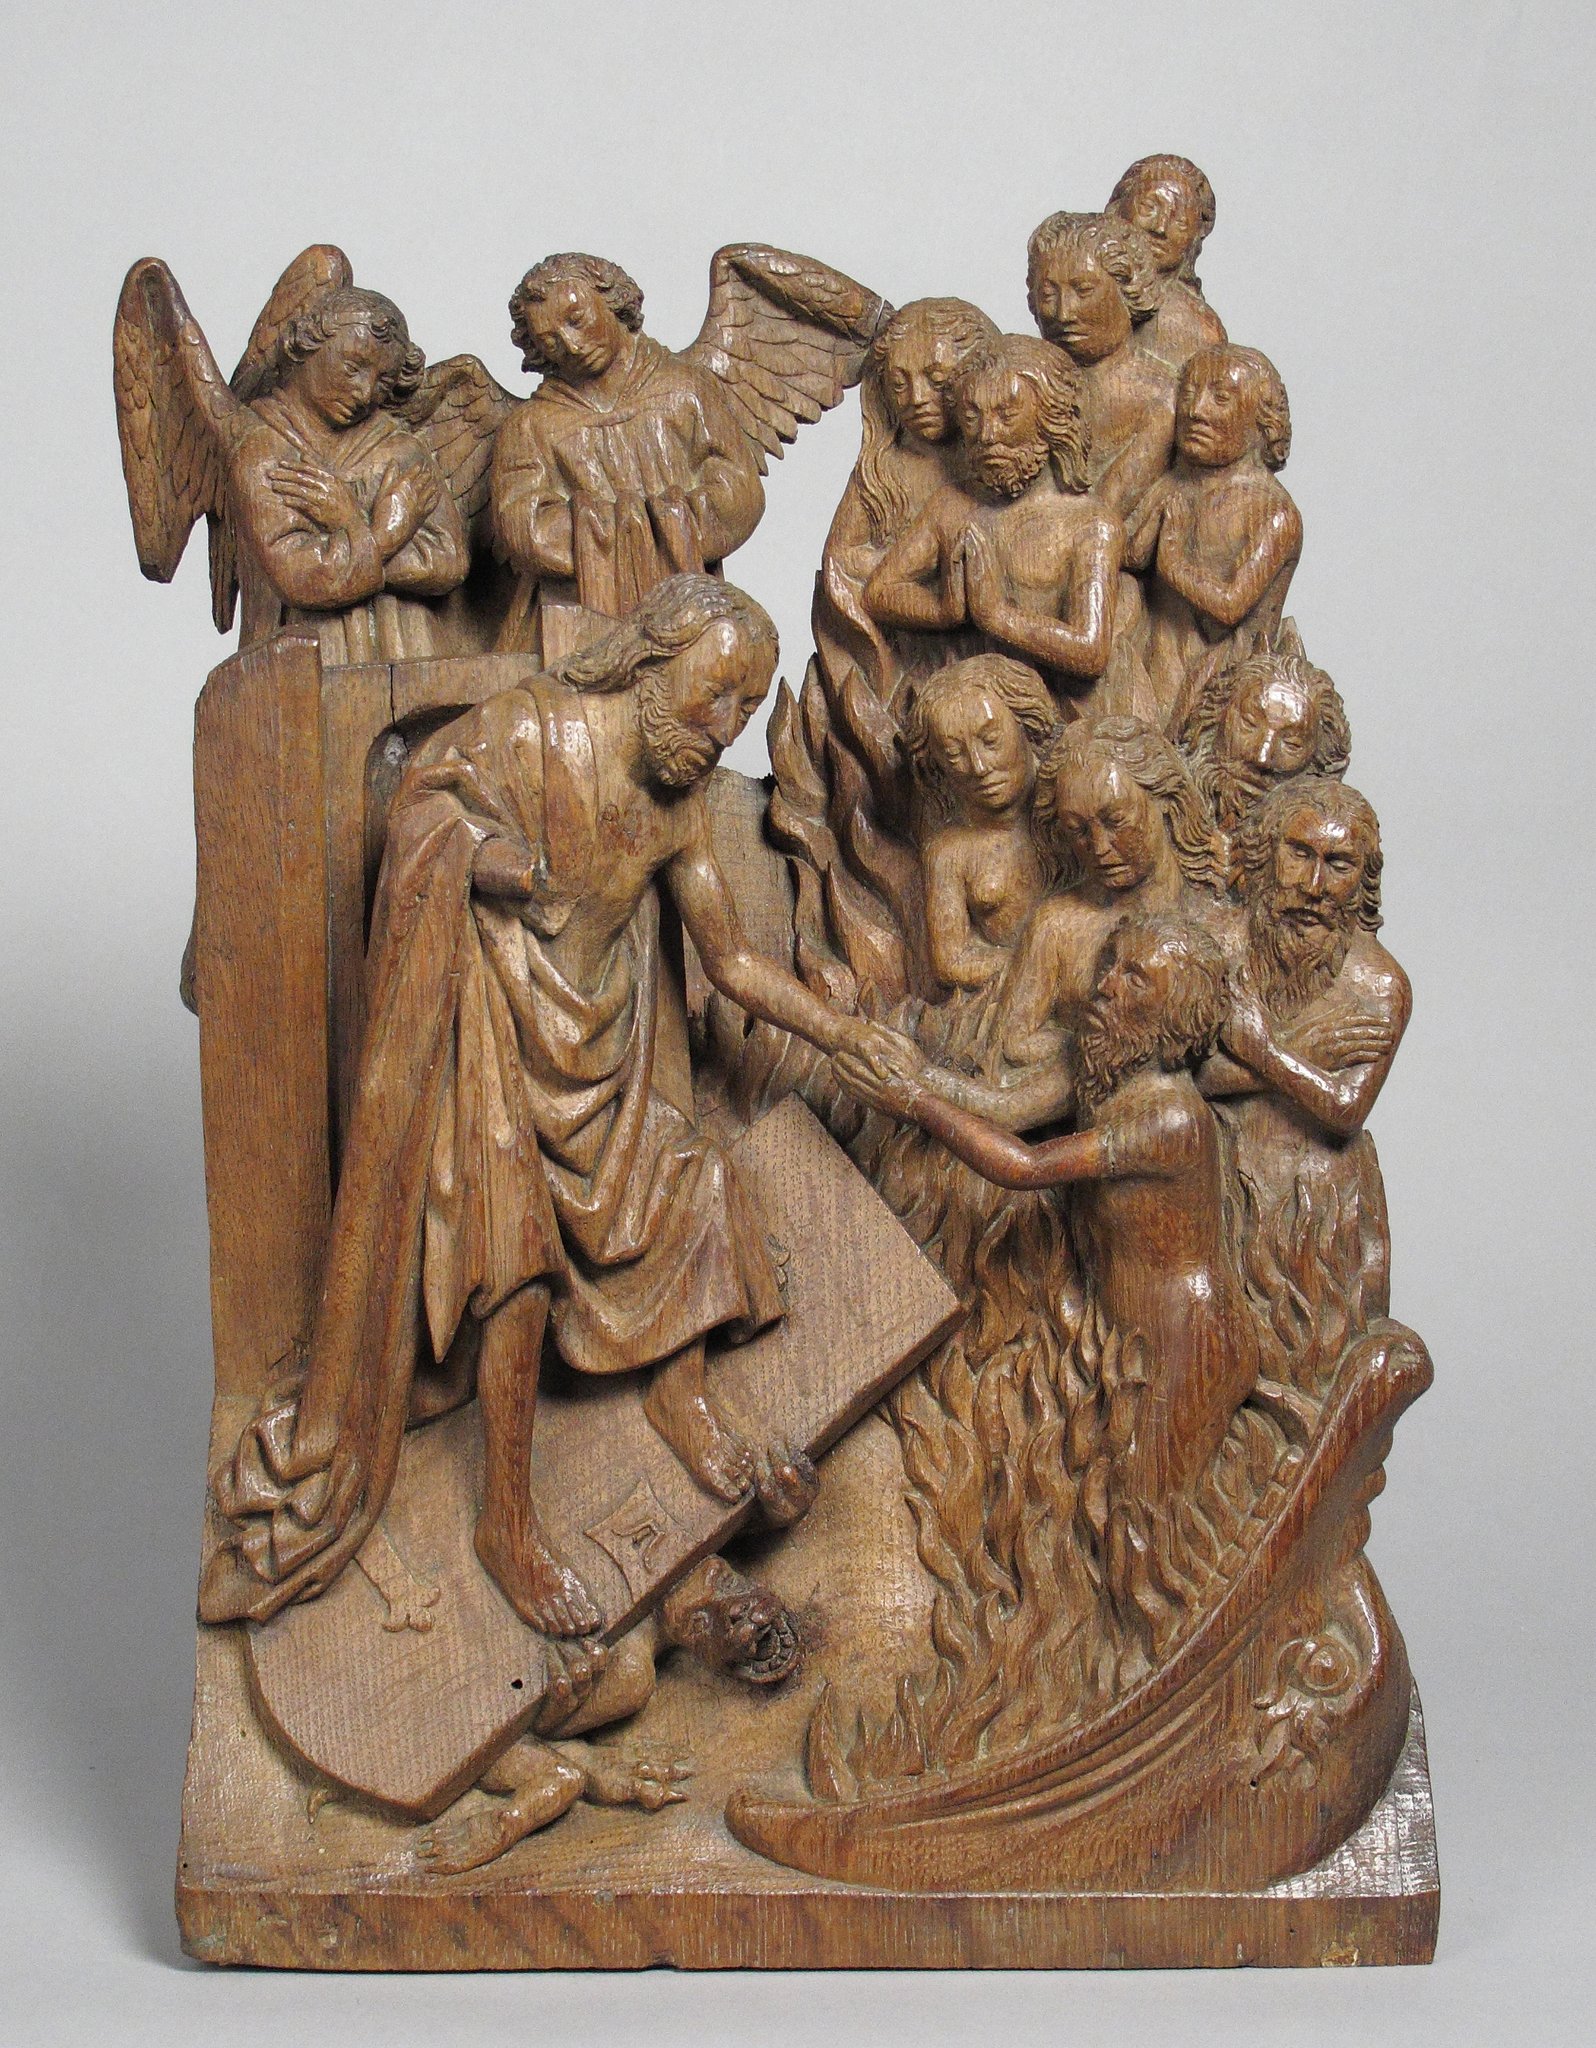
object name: relief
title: Descent into Limbo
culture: french or south netherlandish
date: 1467-1500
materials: wood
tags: men,women,angels,christ